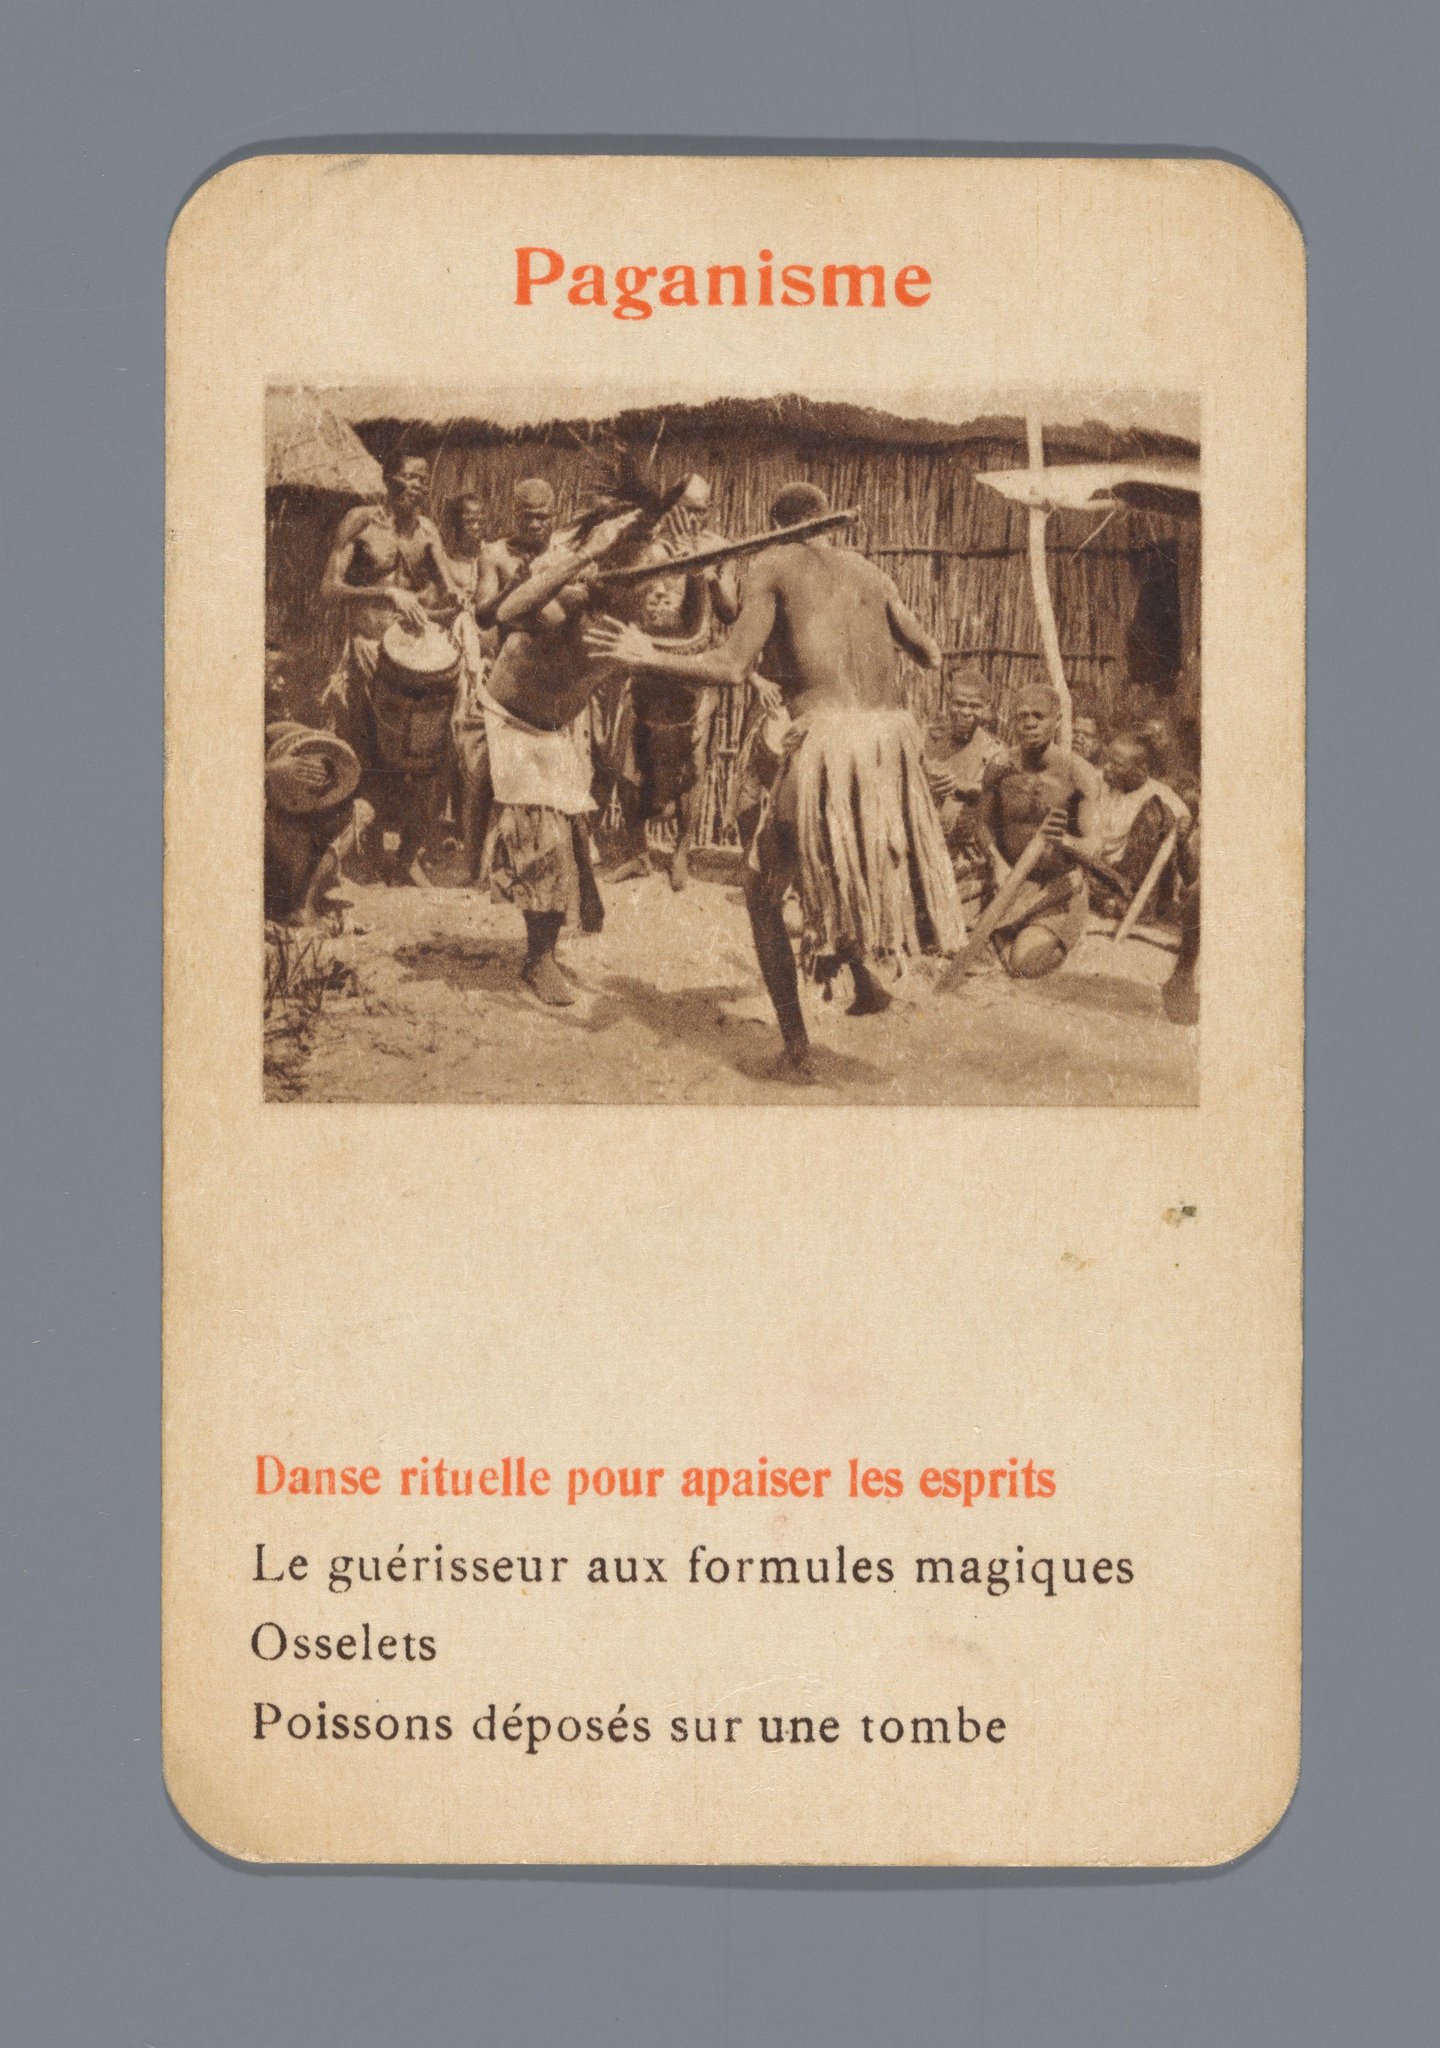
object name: card game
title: Danse rituelle pour apaiser les esprits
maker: Anonymous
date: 1900-1920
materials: cardboard, paper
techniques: rotogravure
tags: african traditional religions, card games